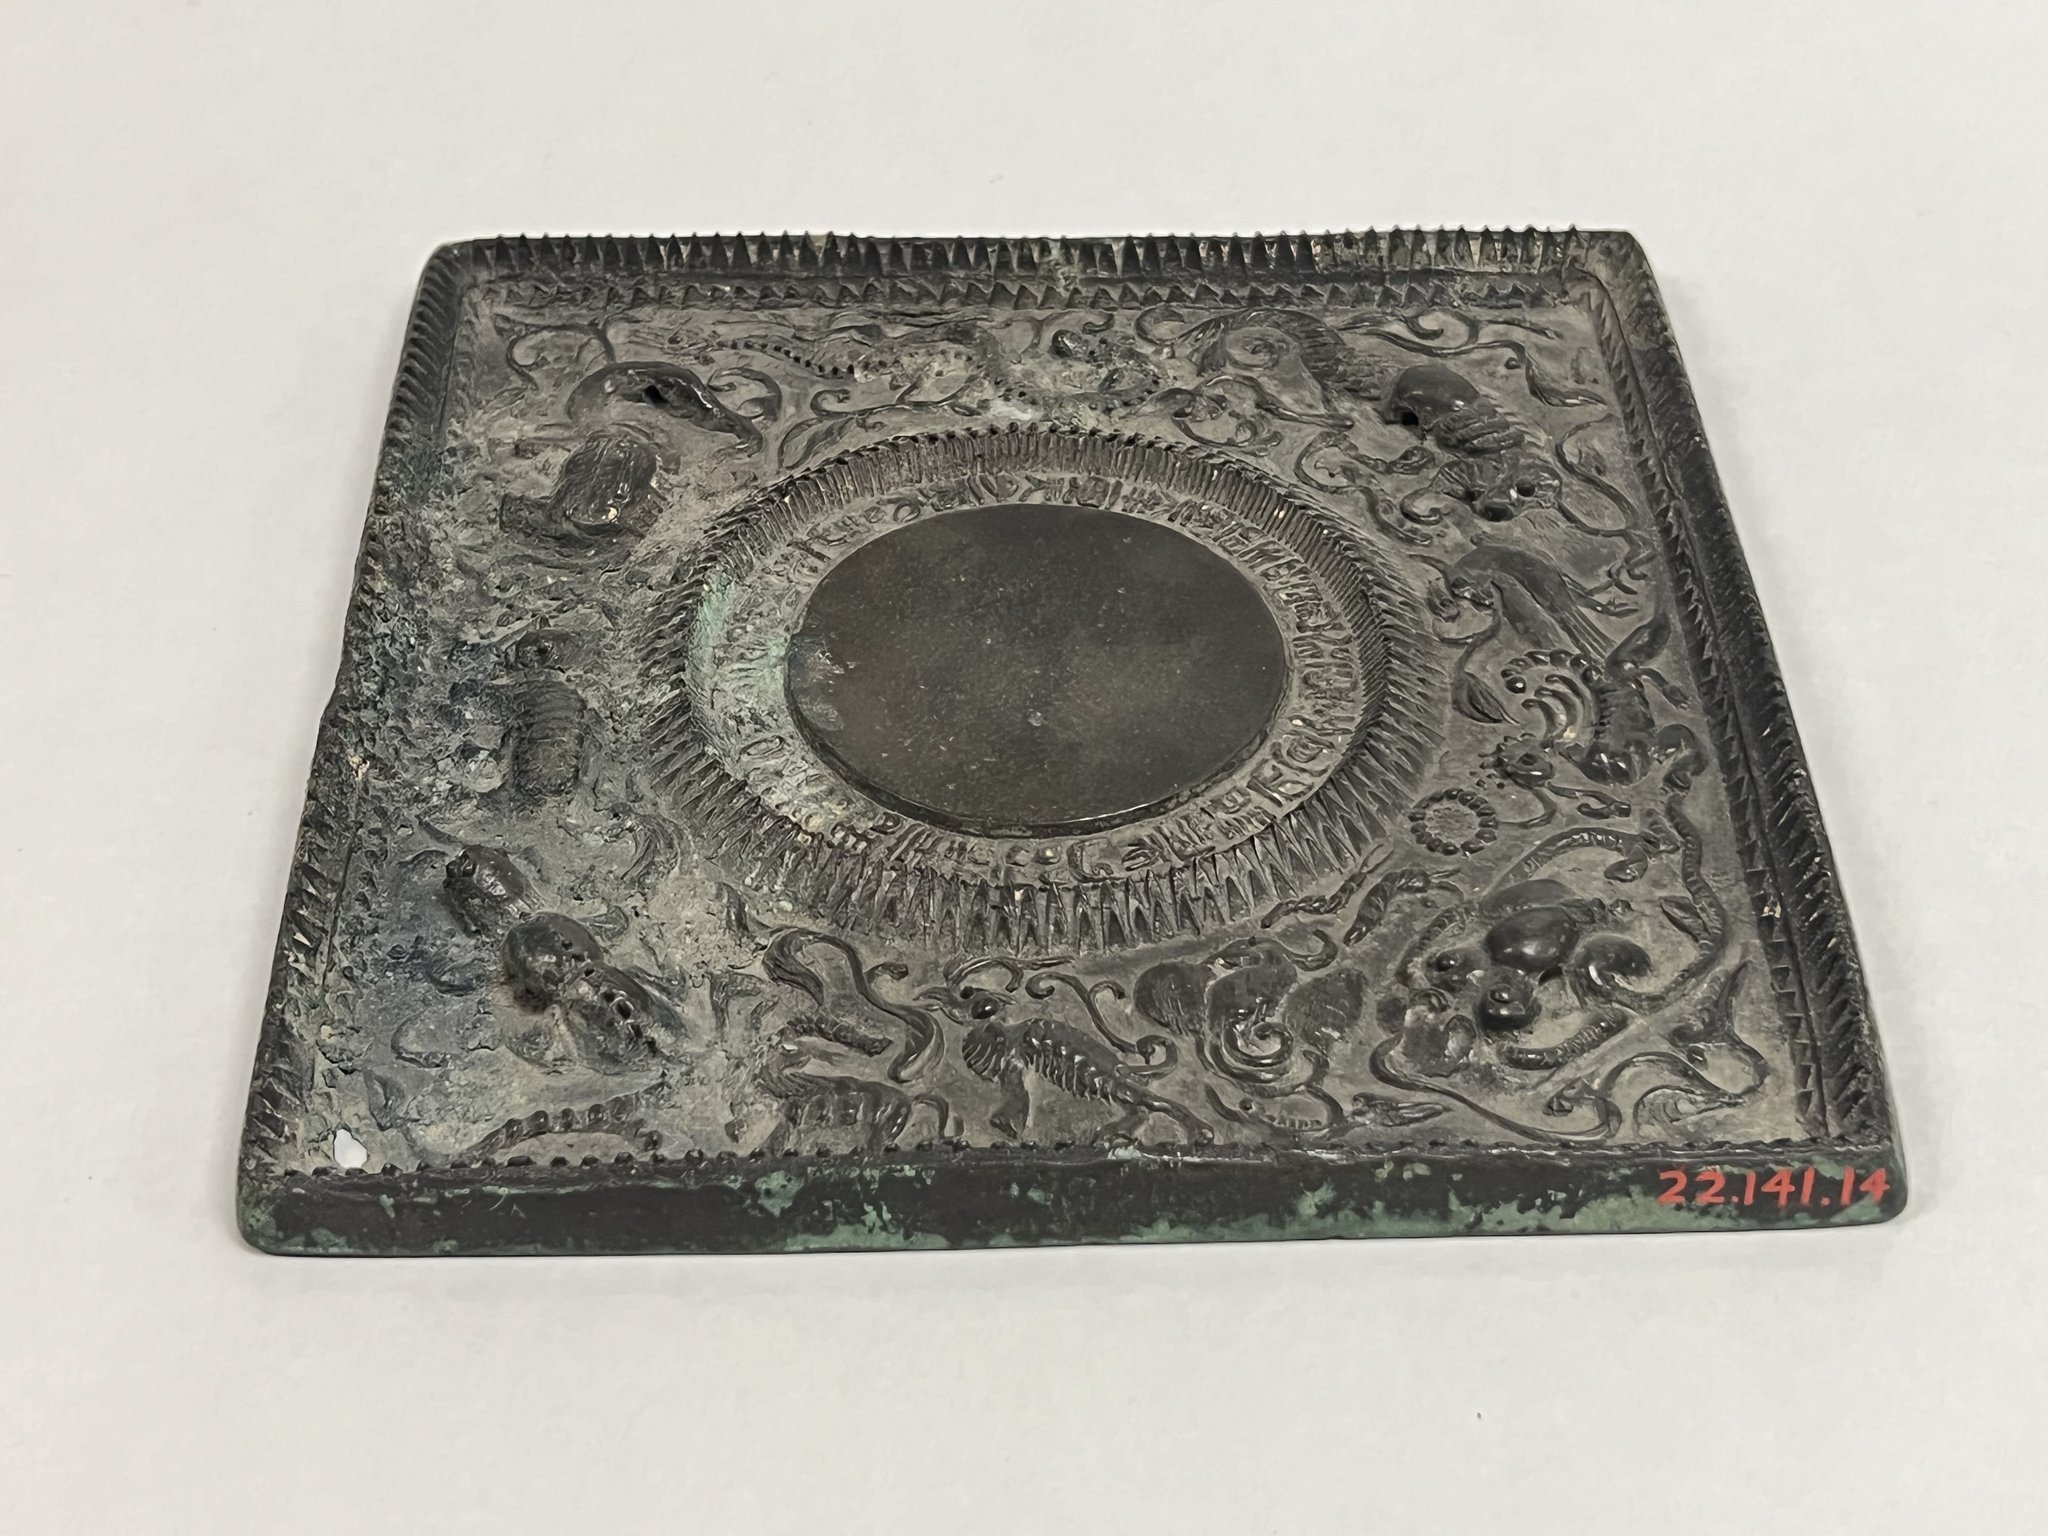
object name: mirror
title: Mirror in a vaguely ancient style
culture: chinese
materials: bronze